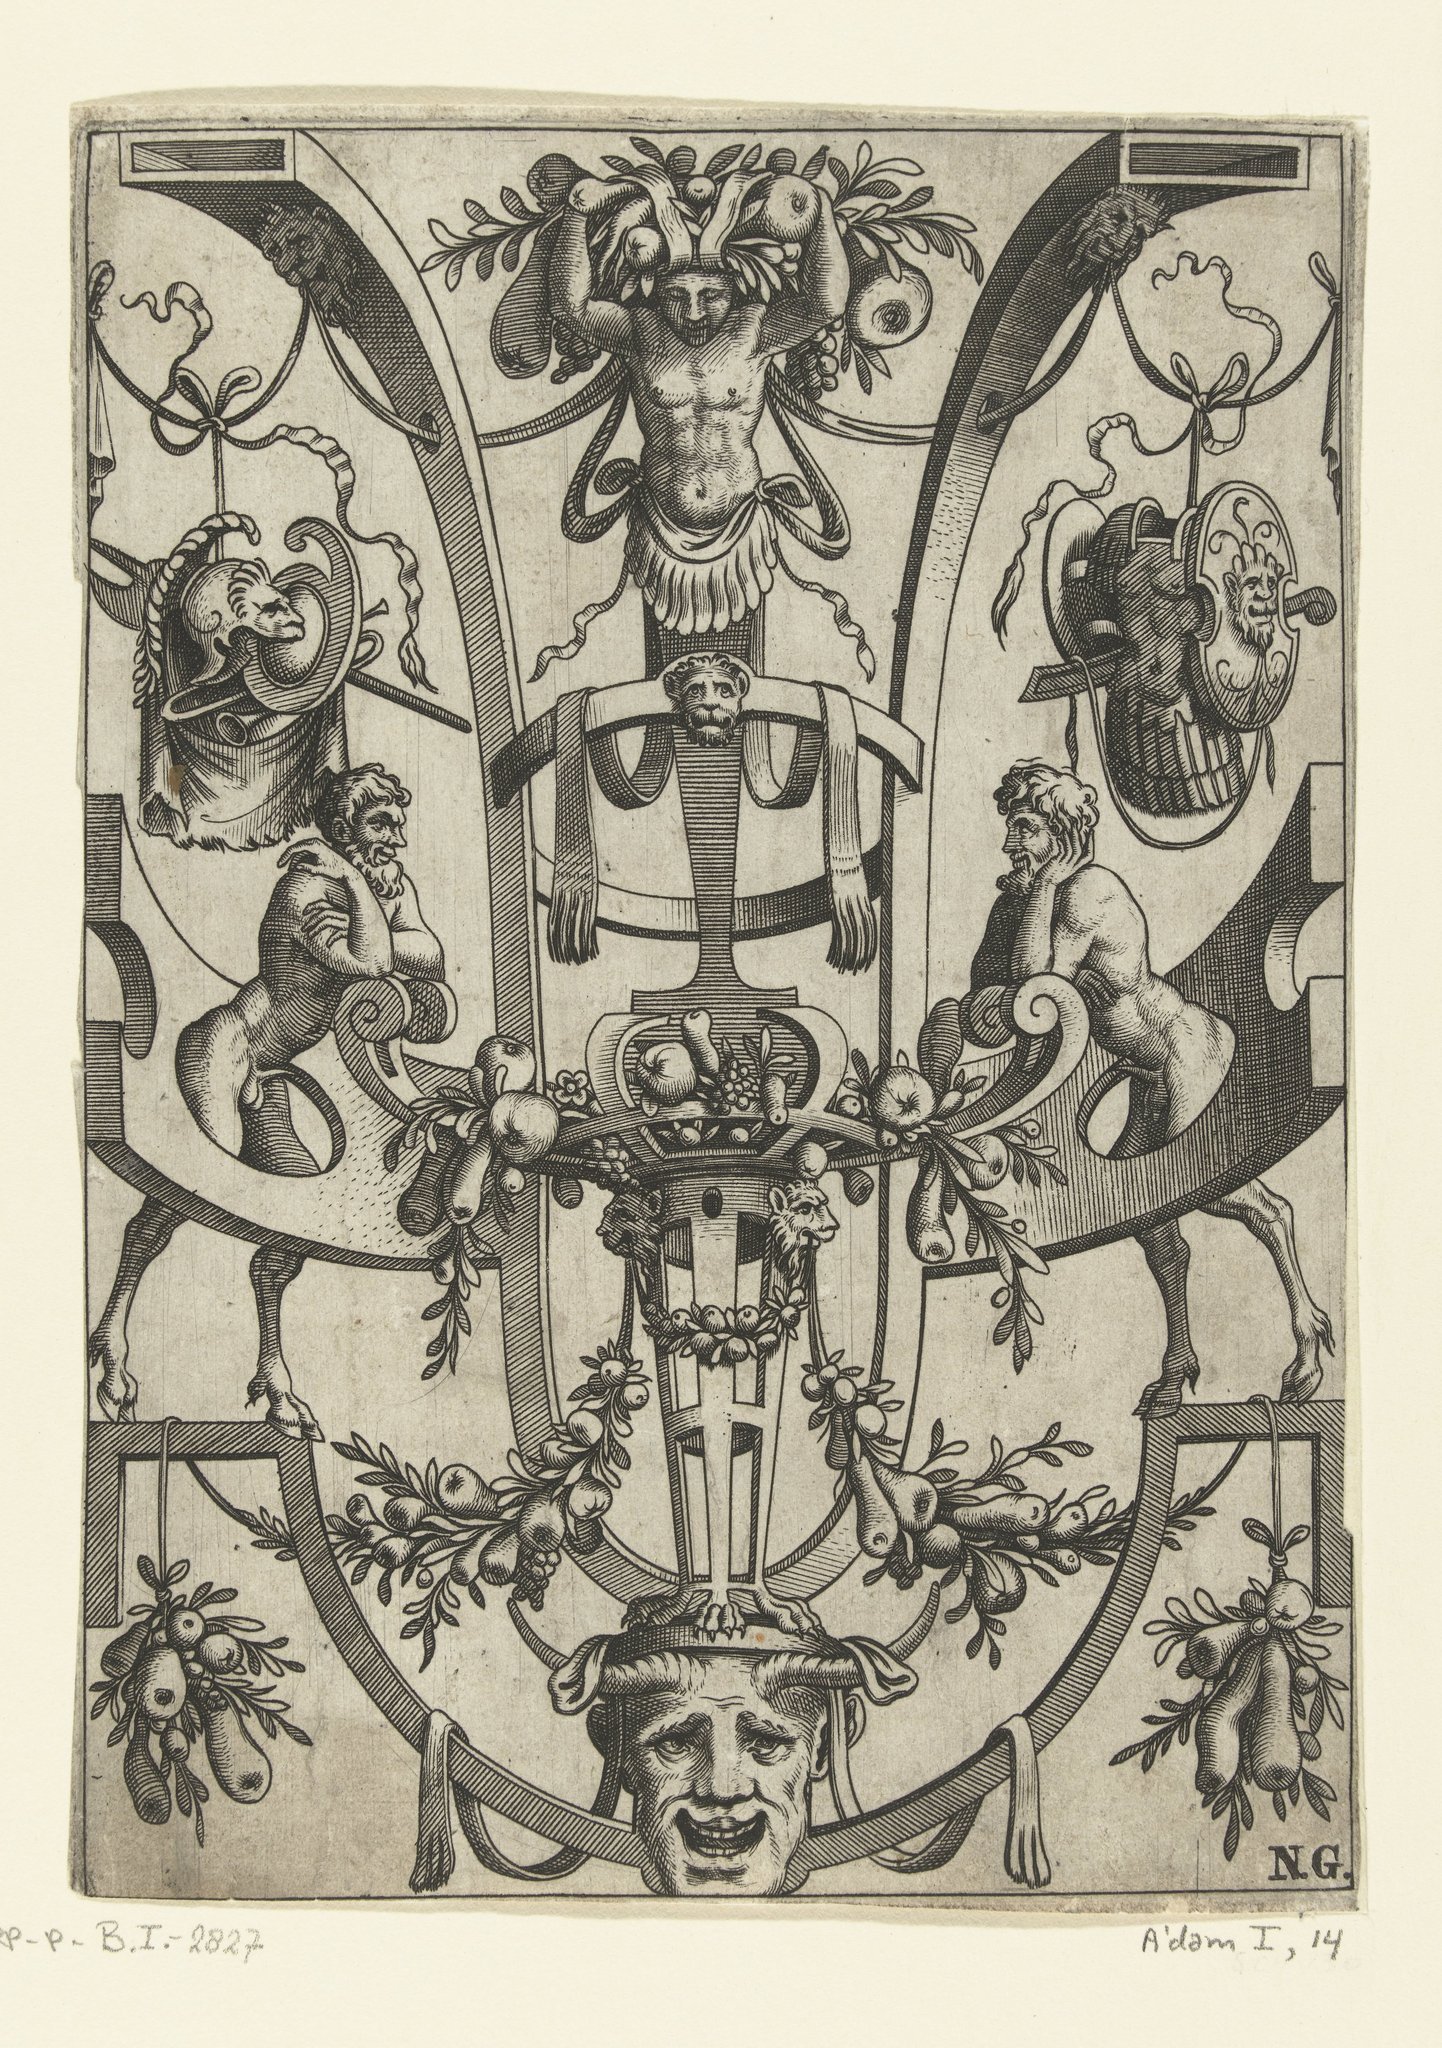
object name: print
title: Vlakdecoratie met rolwerk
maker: Anonymous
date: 1516-1556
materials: paper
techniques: engraving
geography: netherlands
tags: fruits and vegetables ~ ornament, scrollwork, strapwork ~ ornament, mask, mascaron ~ ornament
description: In het midden liggen vruchtentrossen op een drievoetig tafeltje, geflankeerd door twee saters. Op de vruchten staat een herme. Het tafeltje rust op een masker met horens.